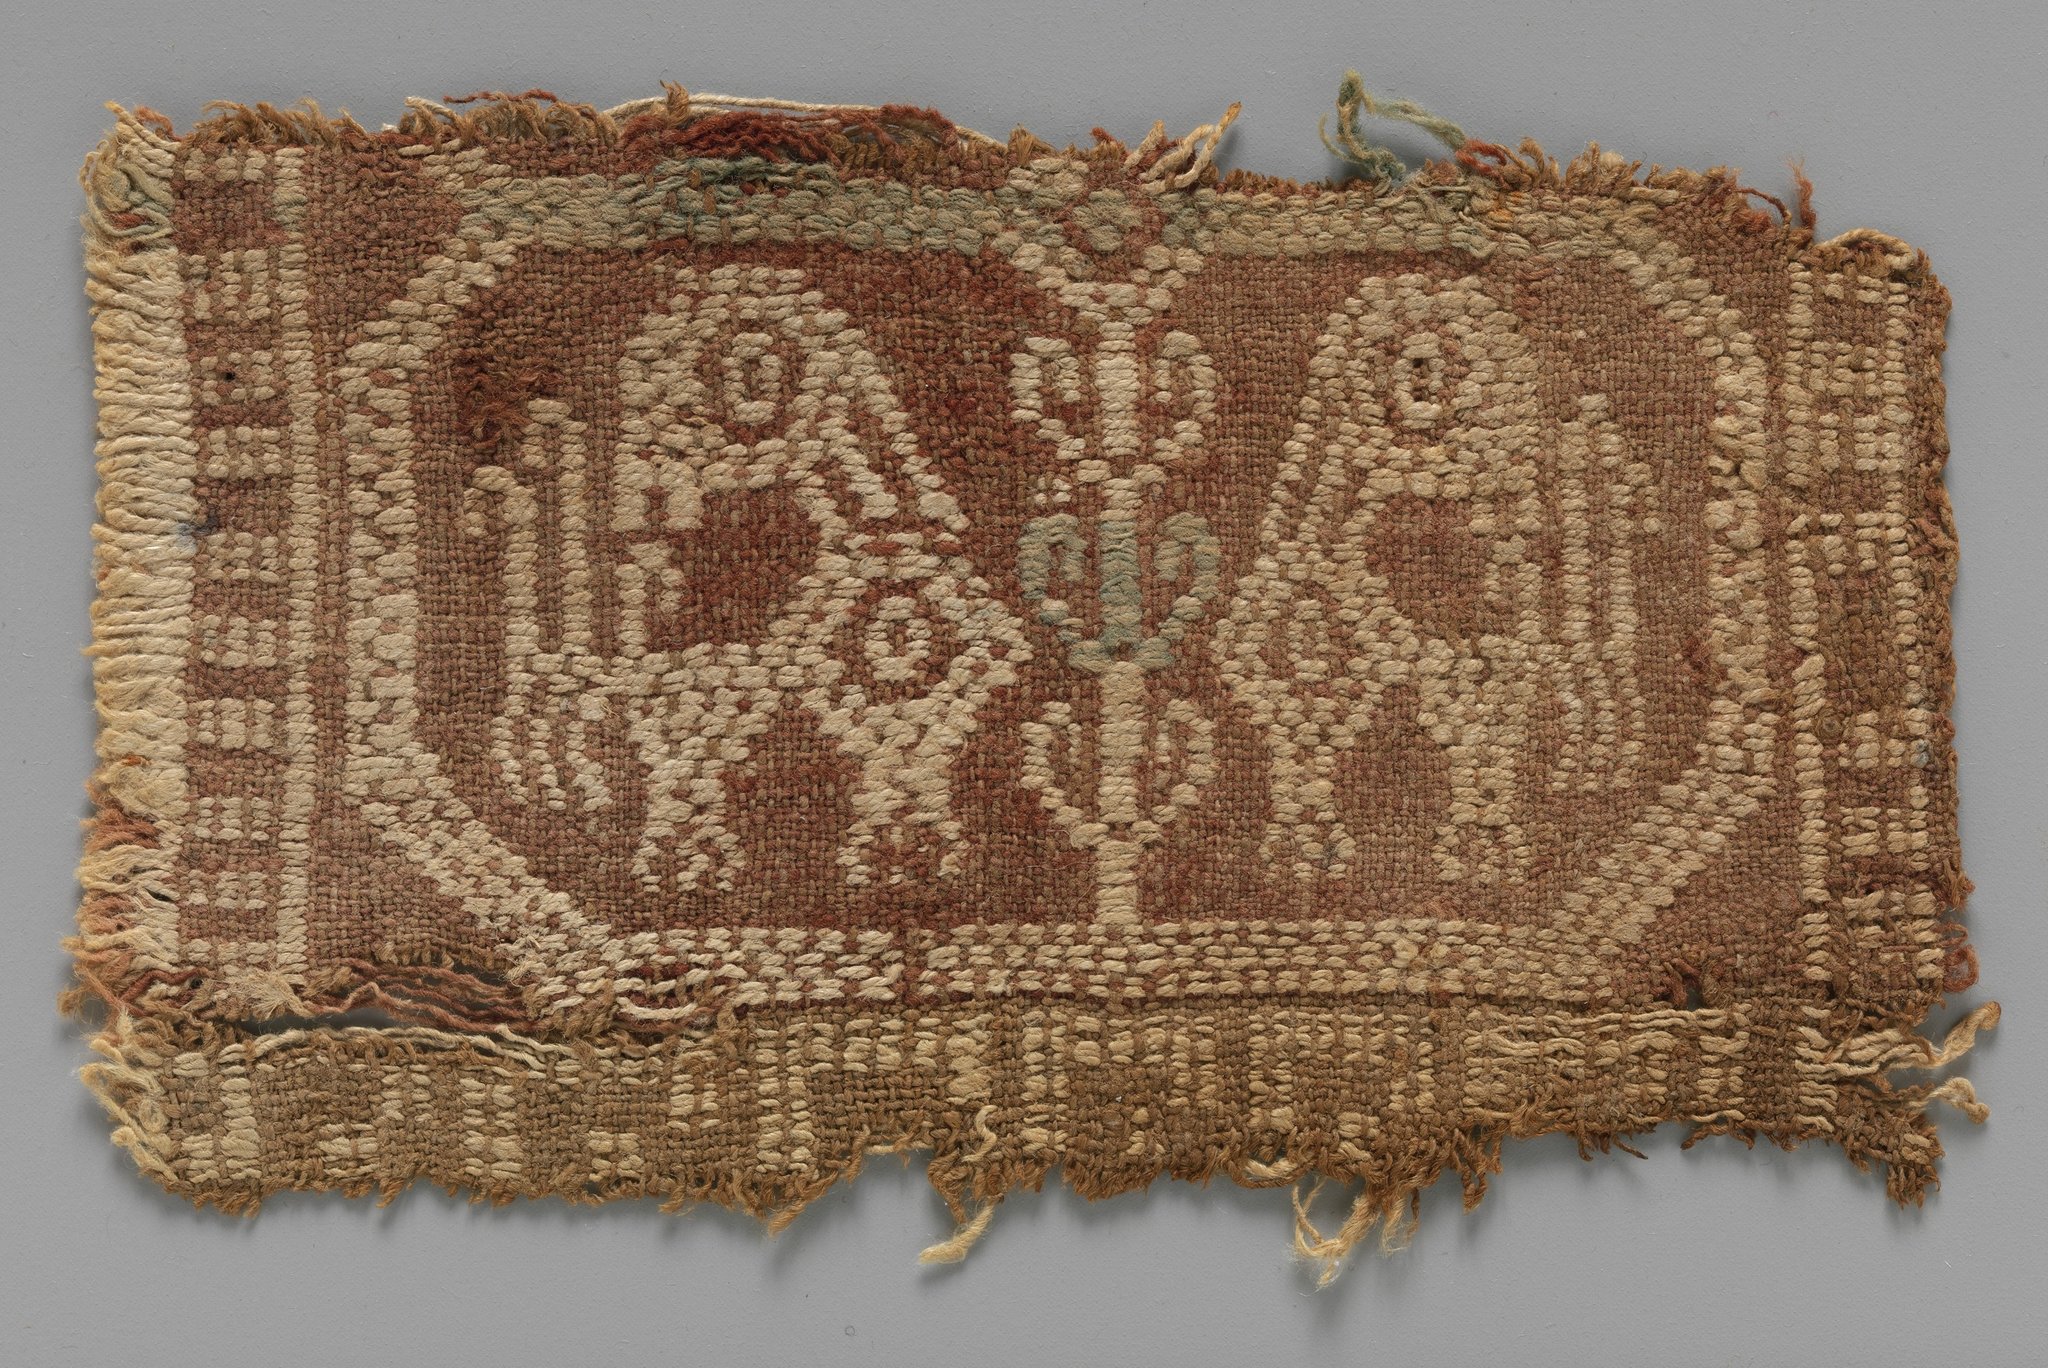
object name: textile fragment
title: Textile Fragment with Birds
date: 701-800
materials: cotton, linen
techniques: brocade, weave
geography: egypt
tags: birds